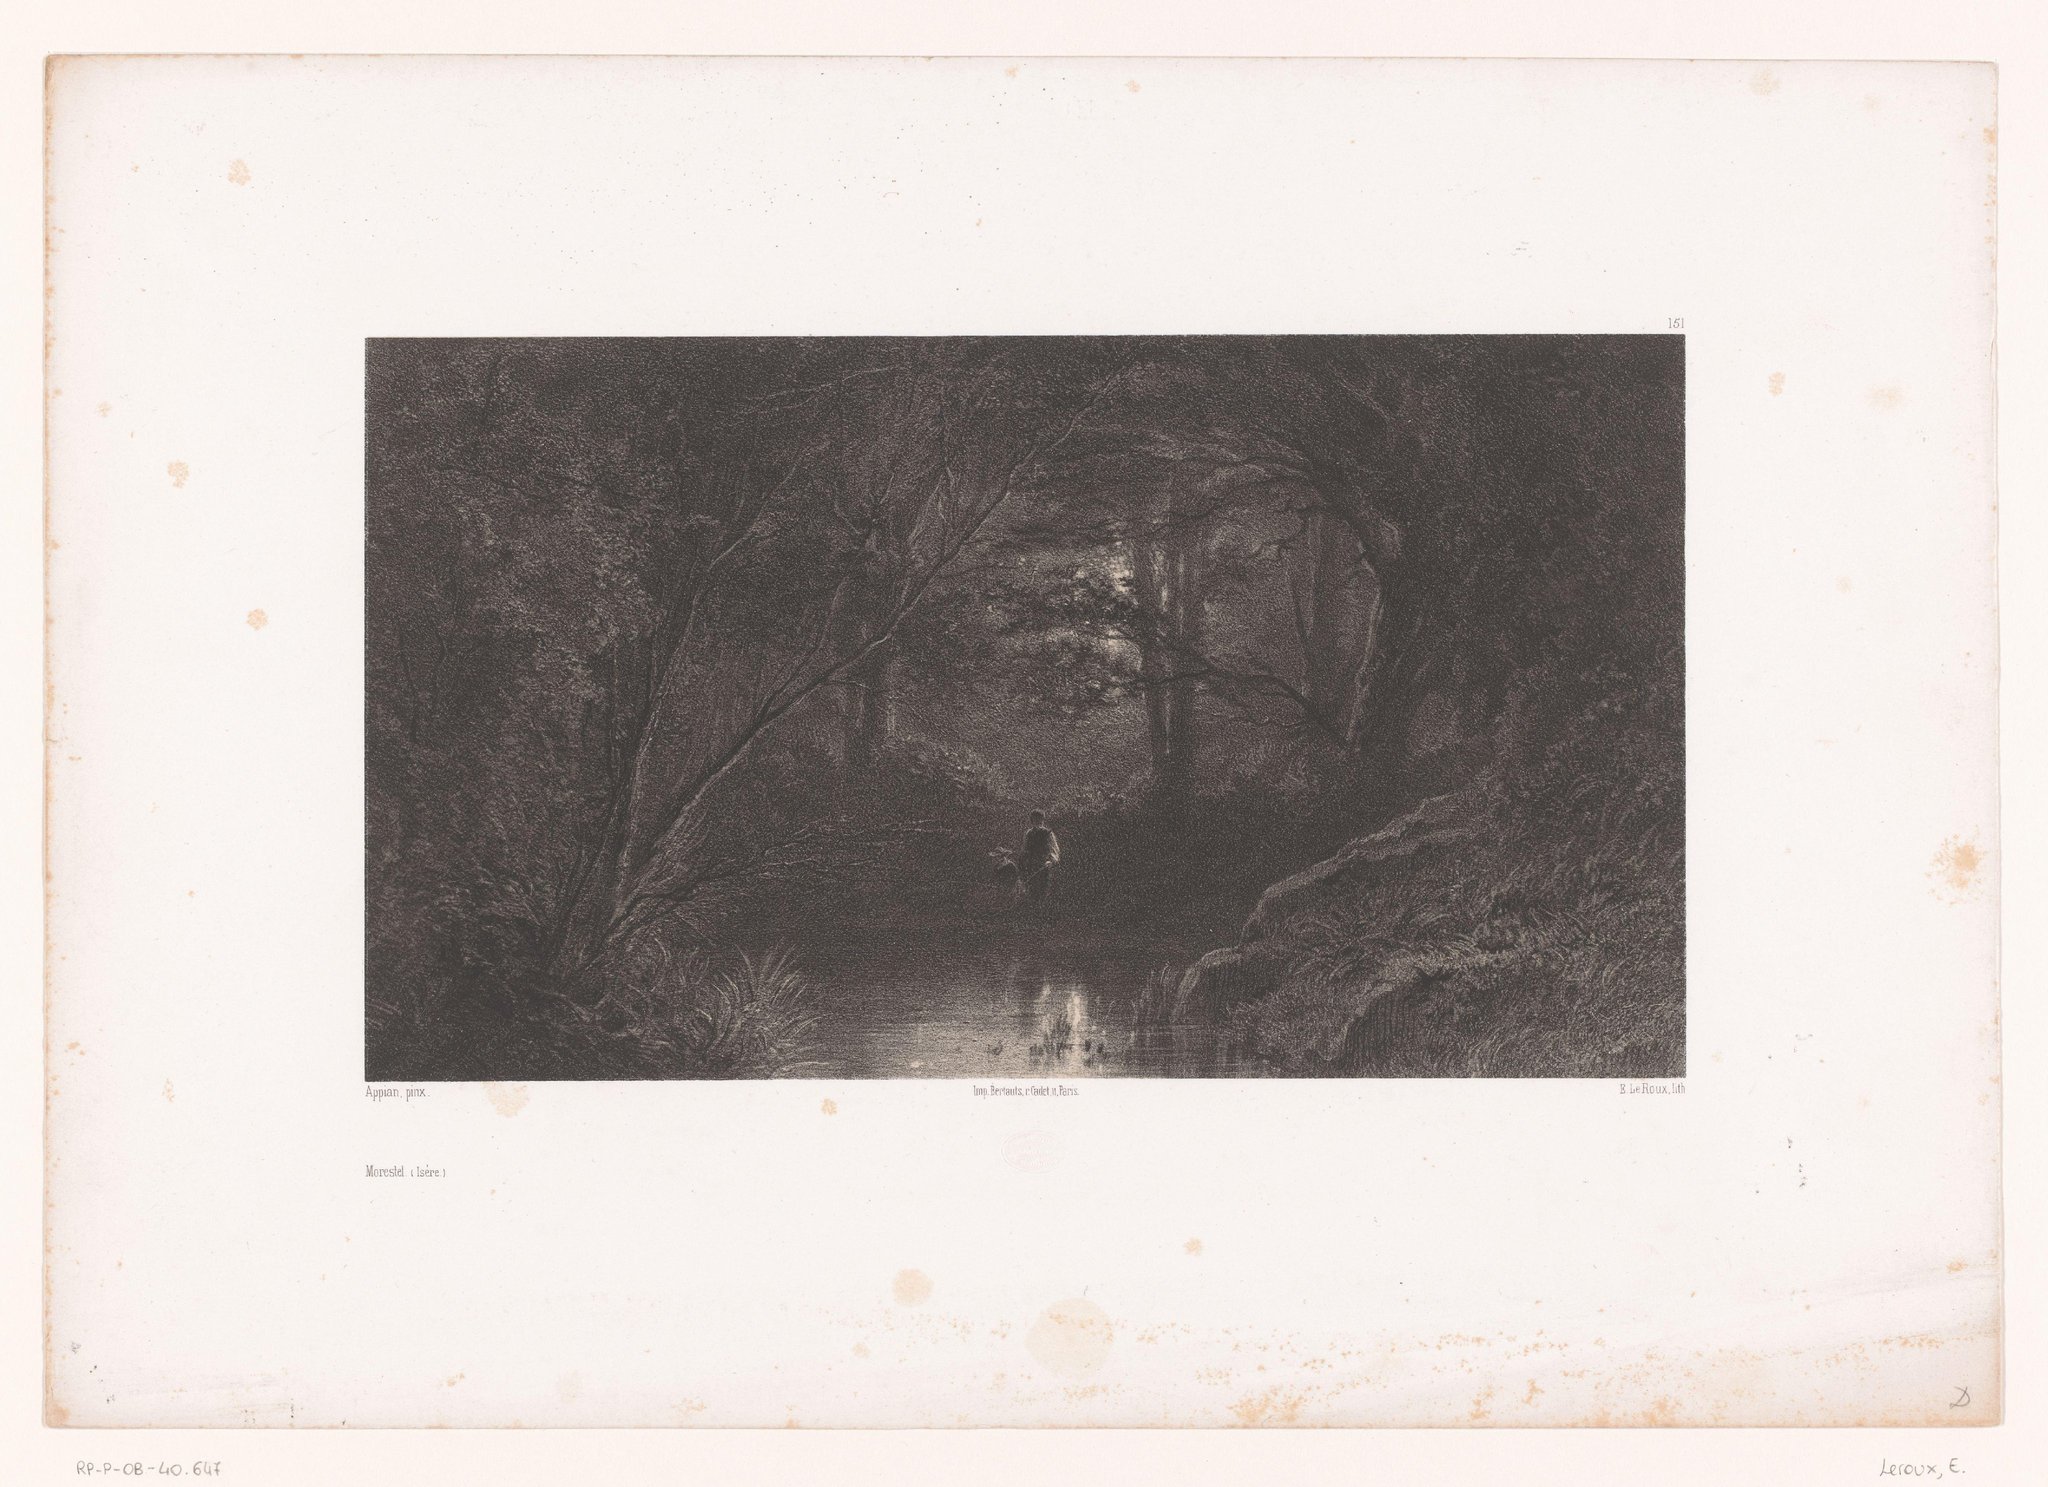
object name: print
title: Morestel (Isère)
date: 1856-1857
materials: paper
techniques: lithography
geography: paris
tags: moonlight, forest, wood (+ landscape with figures, staffage), pond, pool (+ landscape with figures, staffage)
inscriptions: check stamp: Lugt 36a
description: Prent gebruikt voor: Les Artistes anciens et modernes, dl. 4, vol. 7, 1856-1857.